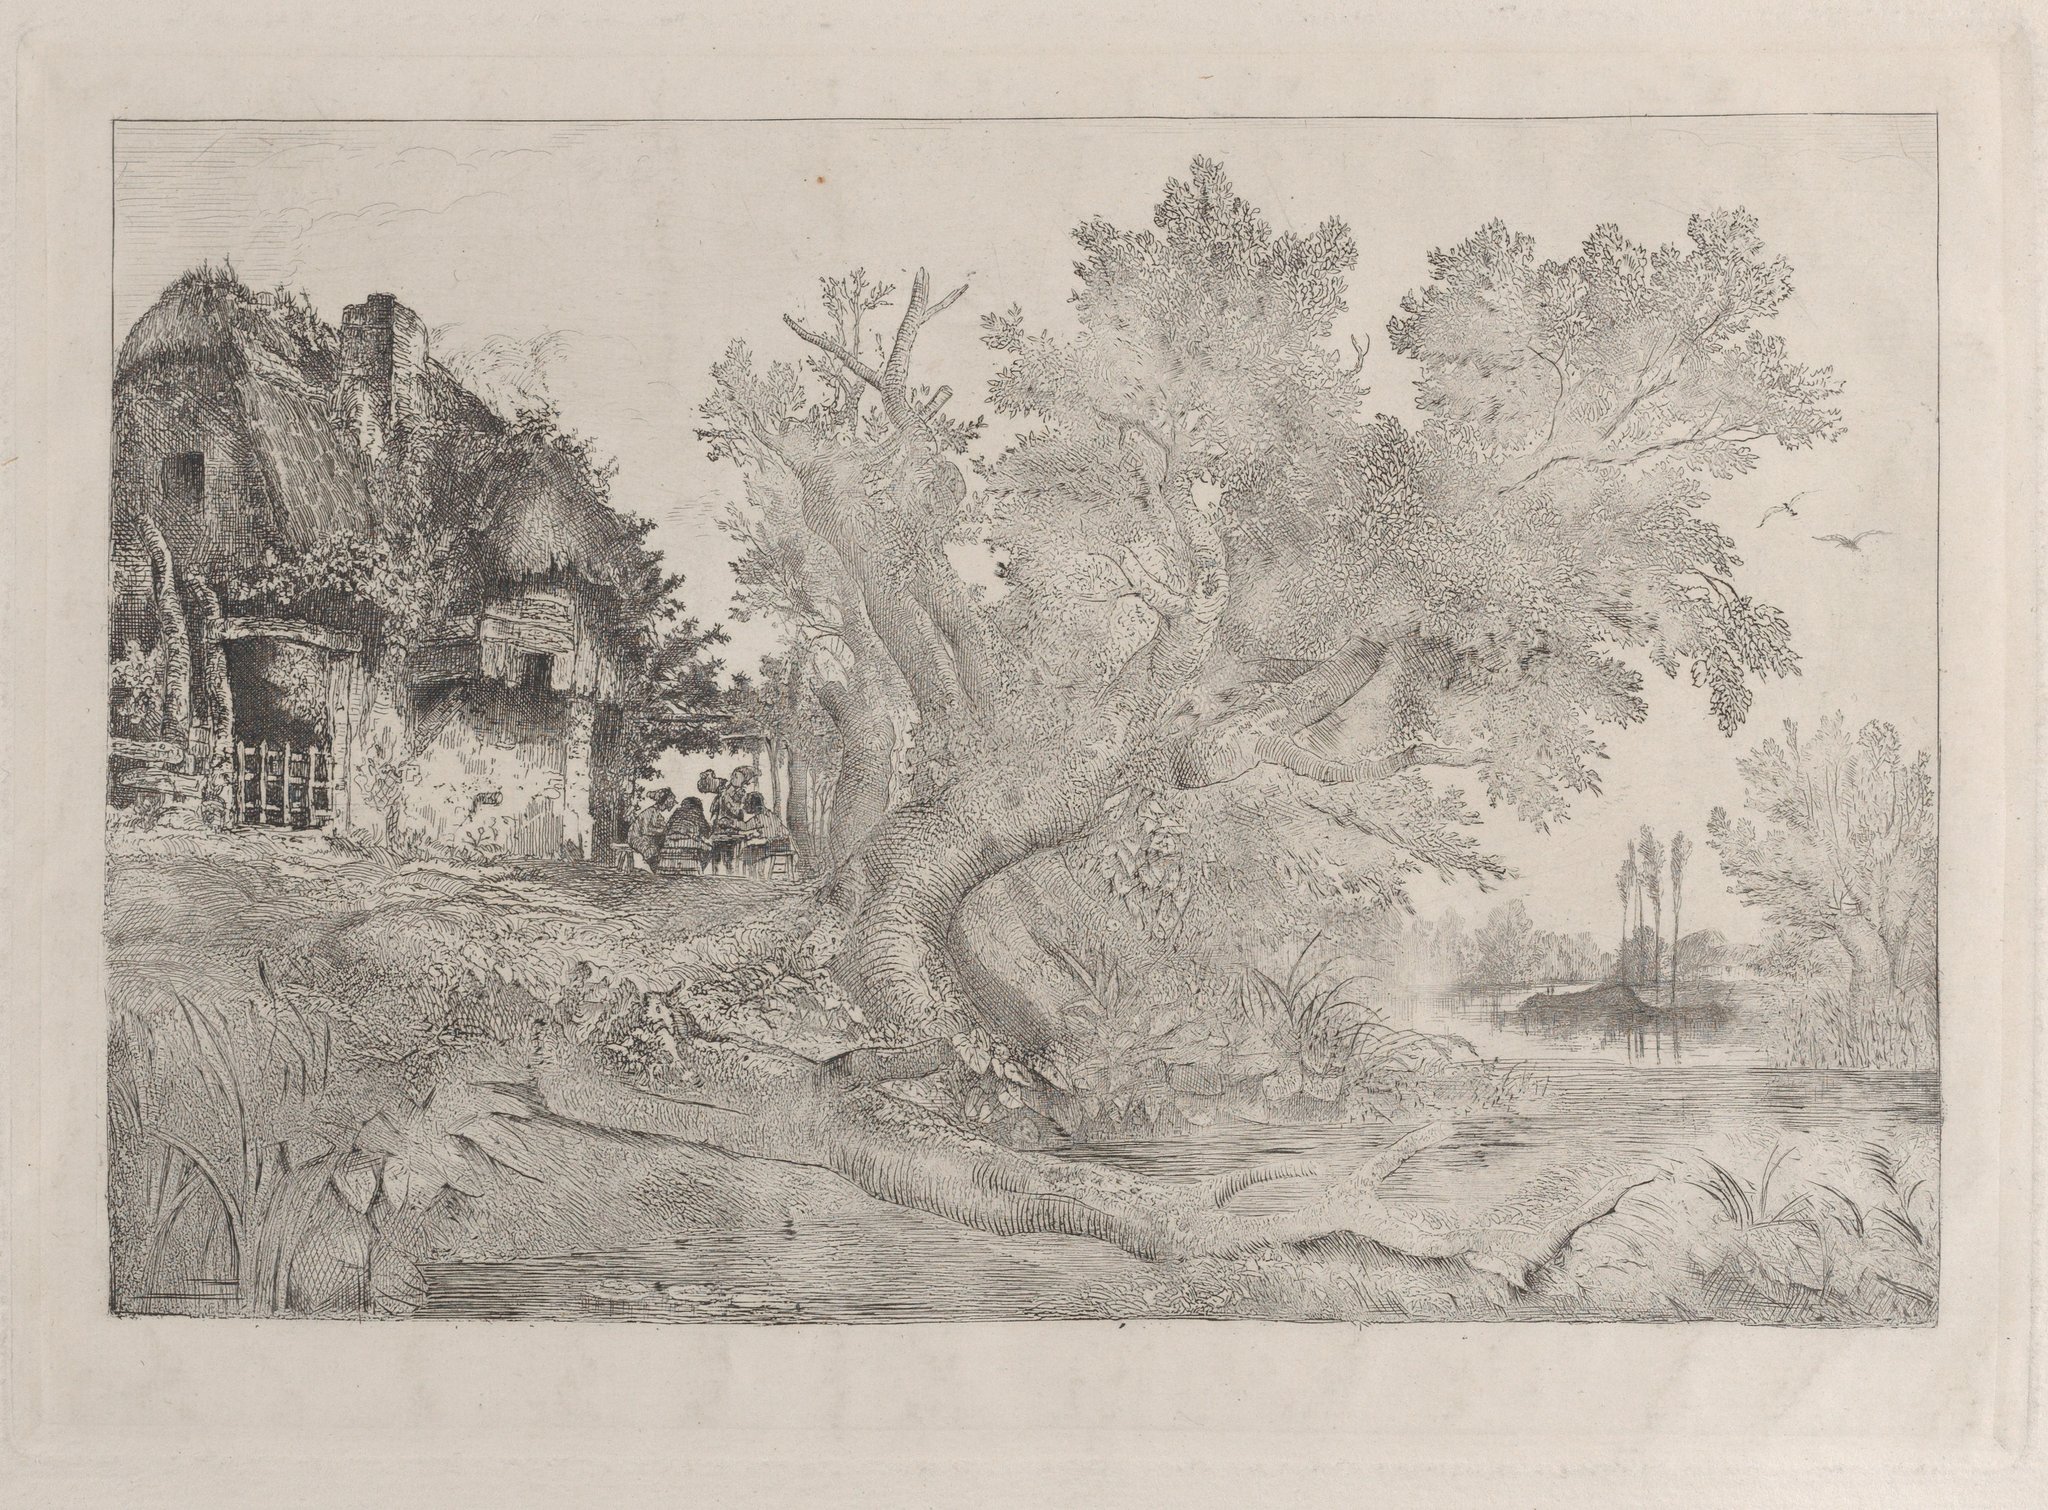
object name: print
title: La Tonnelle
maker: charles-françois daubigny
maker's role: artist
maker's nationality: french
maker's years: 1817-1878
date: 1838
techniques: photogravure